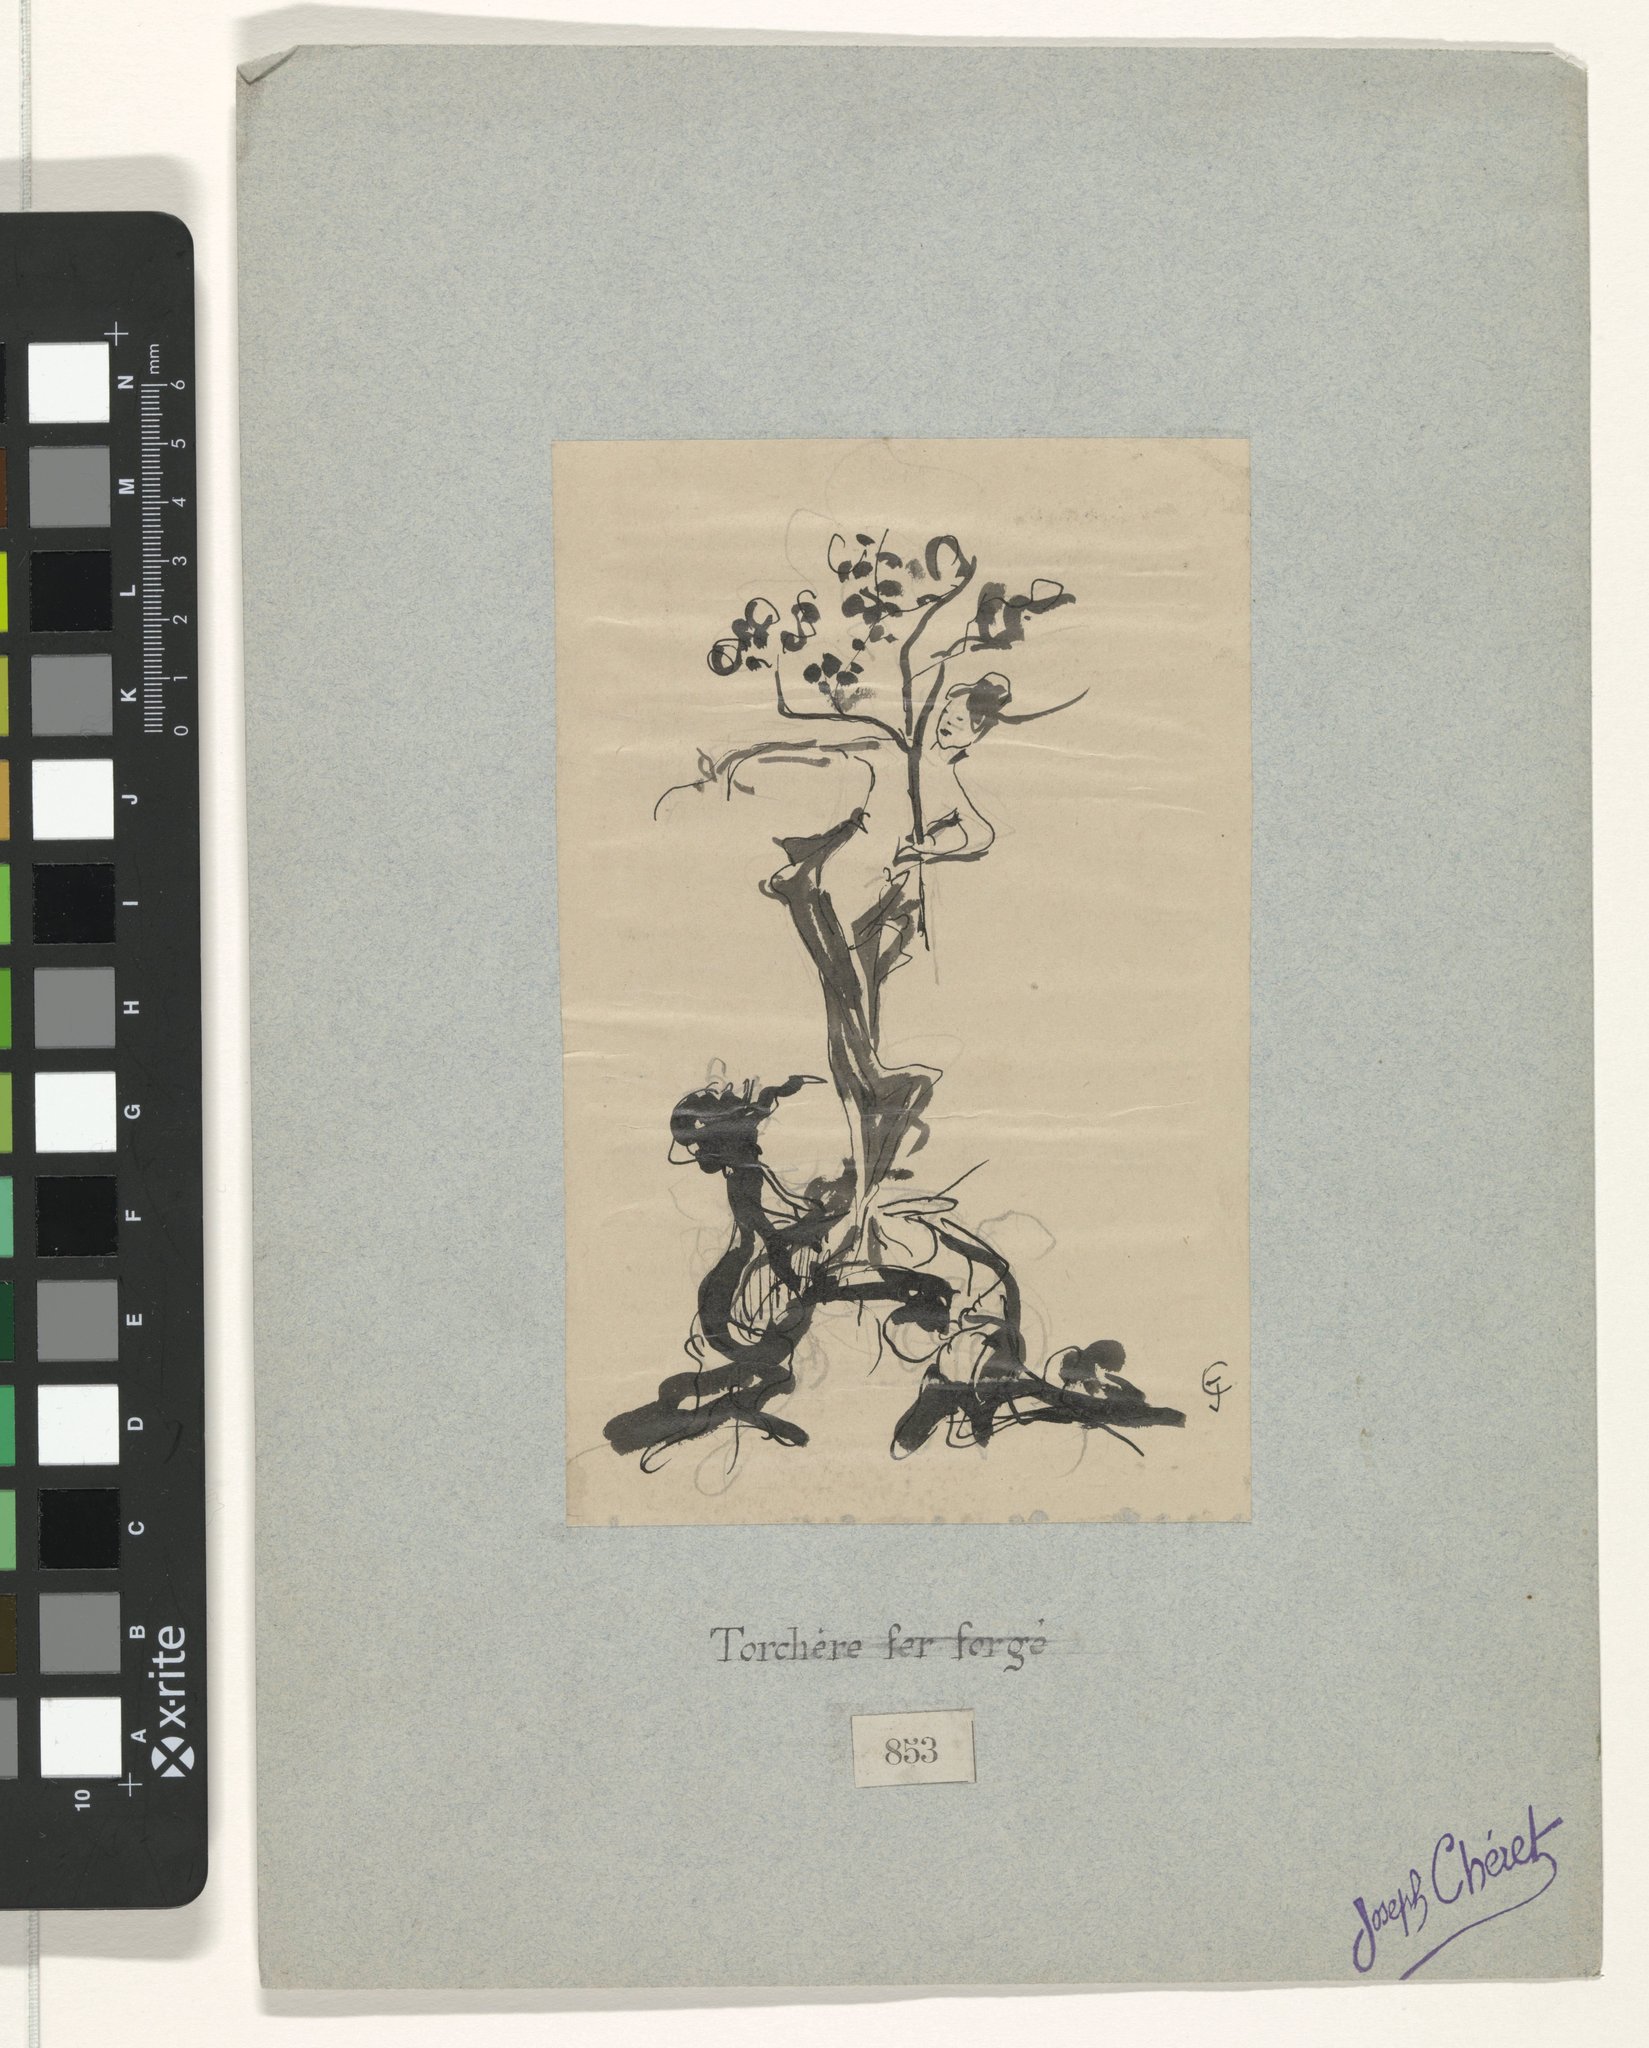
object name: design drawing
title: Torchère met vrouwenfiguur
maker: gustave joseph chéret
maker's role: sculptor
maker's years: 1838-1894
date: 1870-1894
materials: cardboard, graphite, ink, paper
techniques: brush, pen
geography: paris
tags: chandelier, candelabrum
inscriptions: inscription: ‘550’, monogram: ‘JC’, workshop stamp: ‘Joseph Chéret’, inscription: ‘Torchère fer forgé’, label: ‘853’